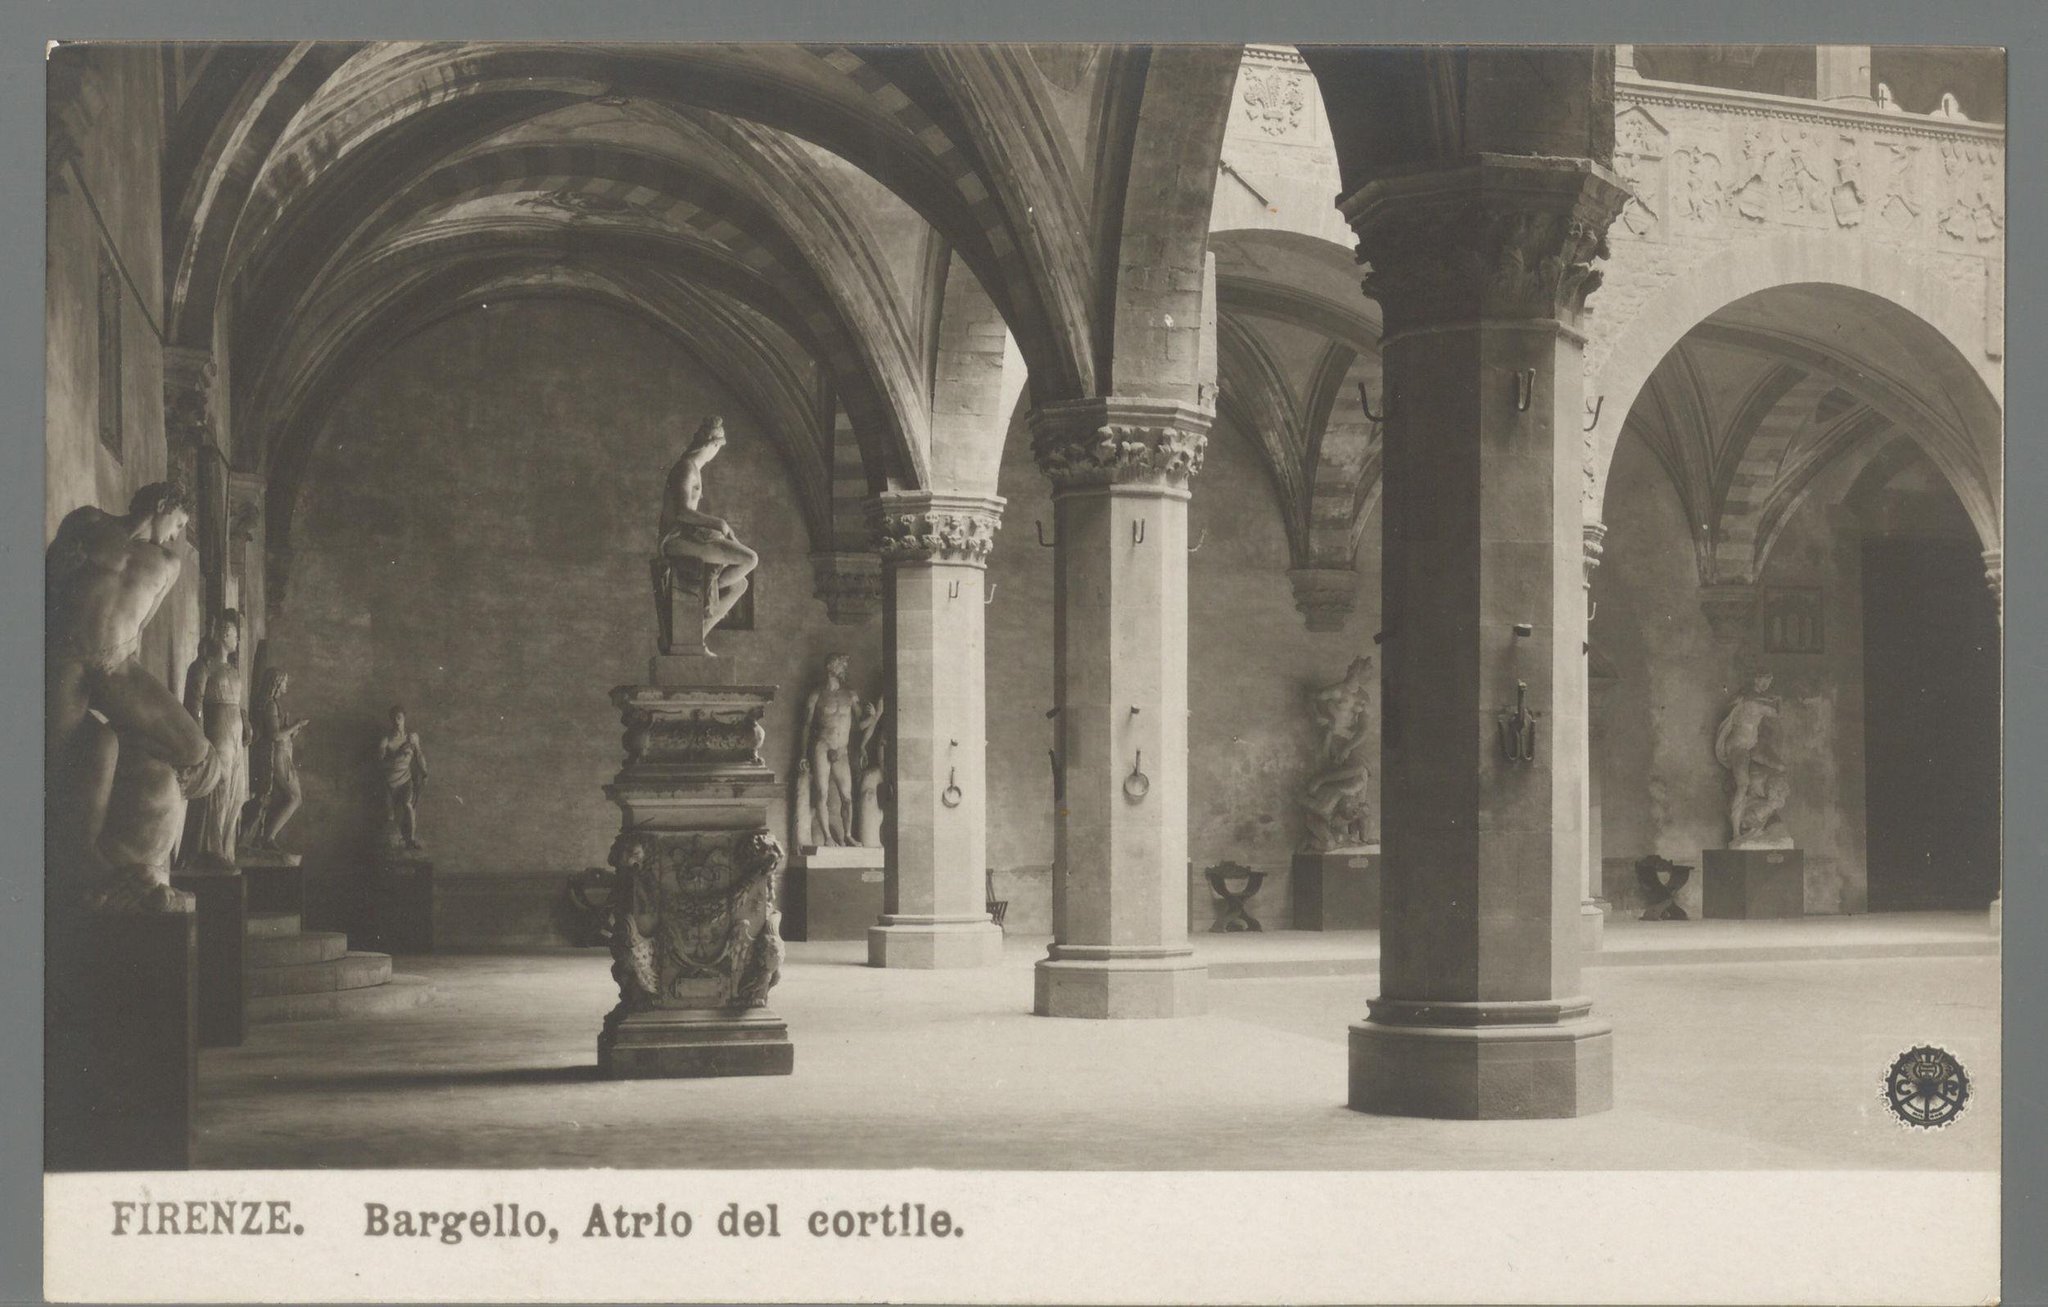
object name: ansichtkaart, prentbriefkaart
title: Firenze. Bargello, Atrio del cortile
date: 1900-1906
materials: paper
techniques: gelatin silver print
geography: florence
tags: sculpture, inner court of palace or 'hôtel'